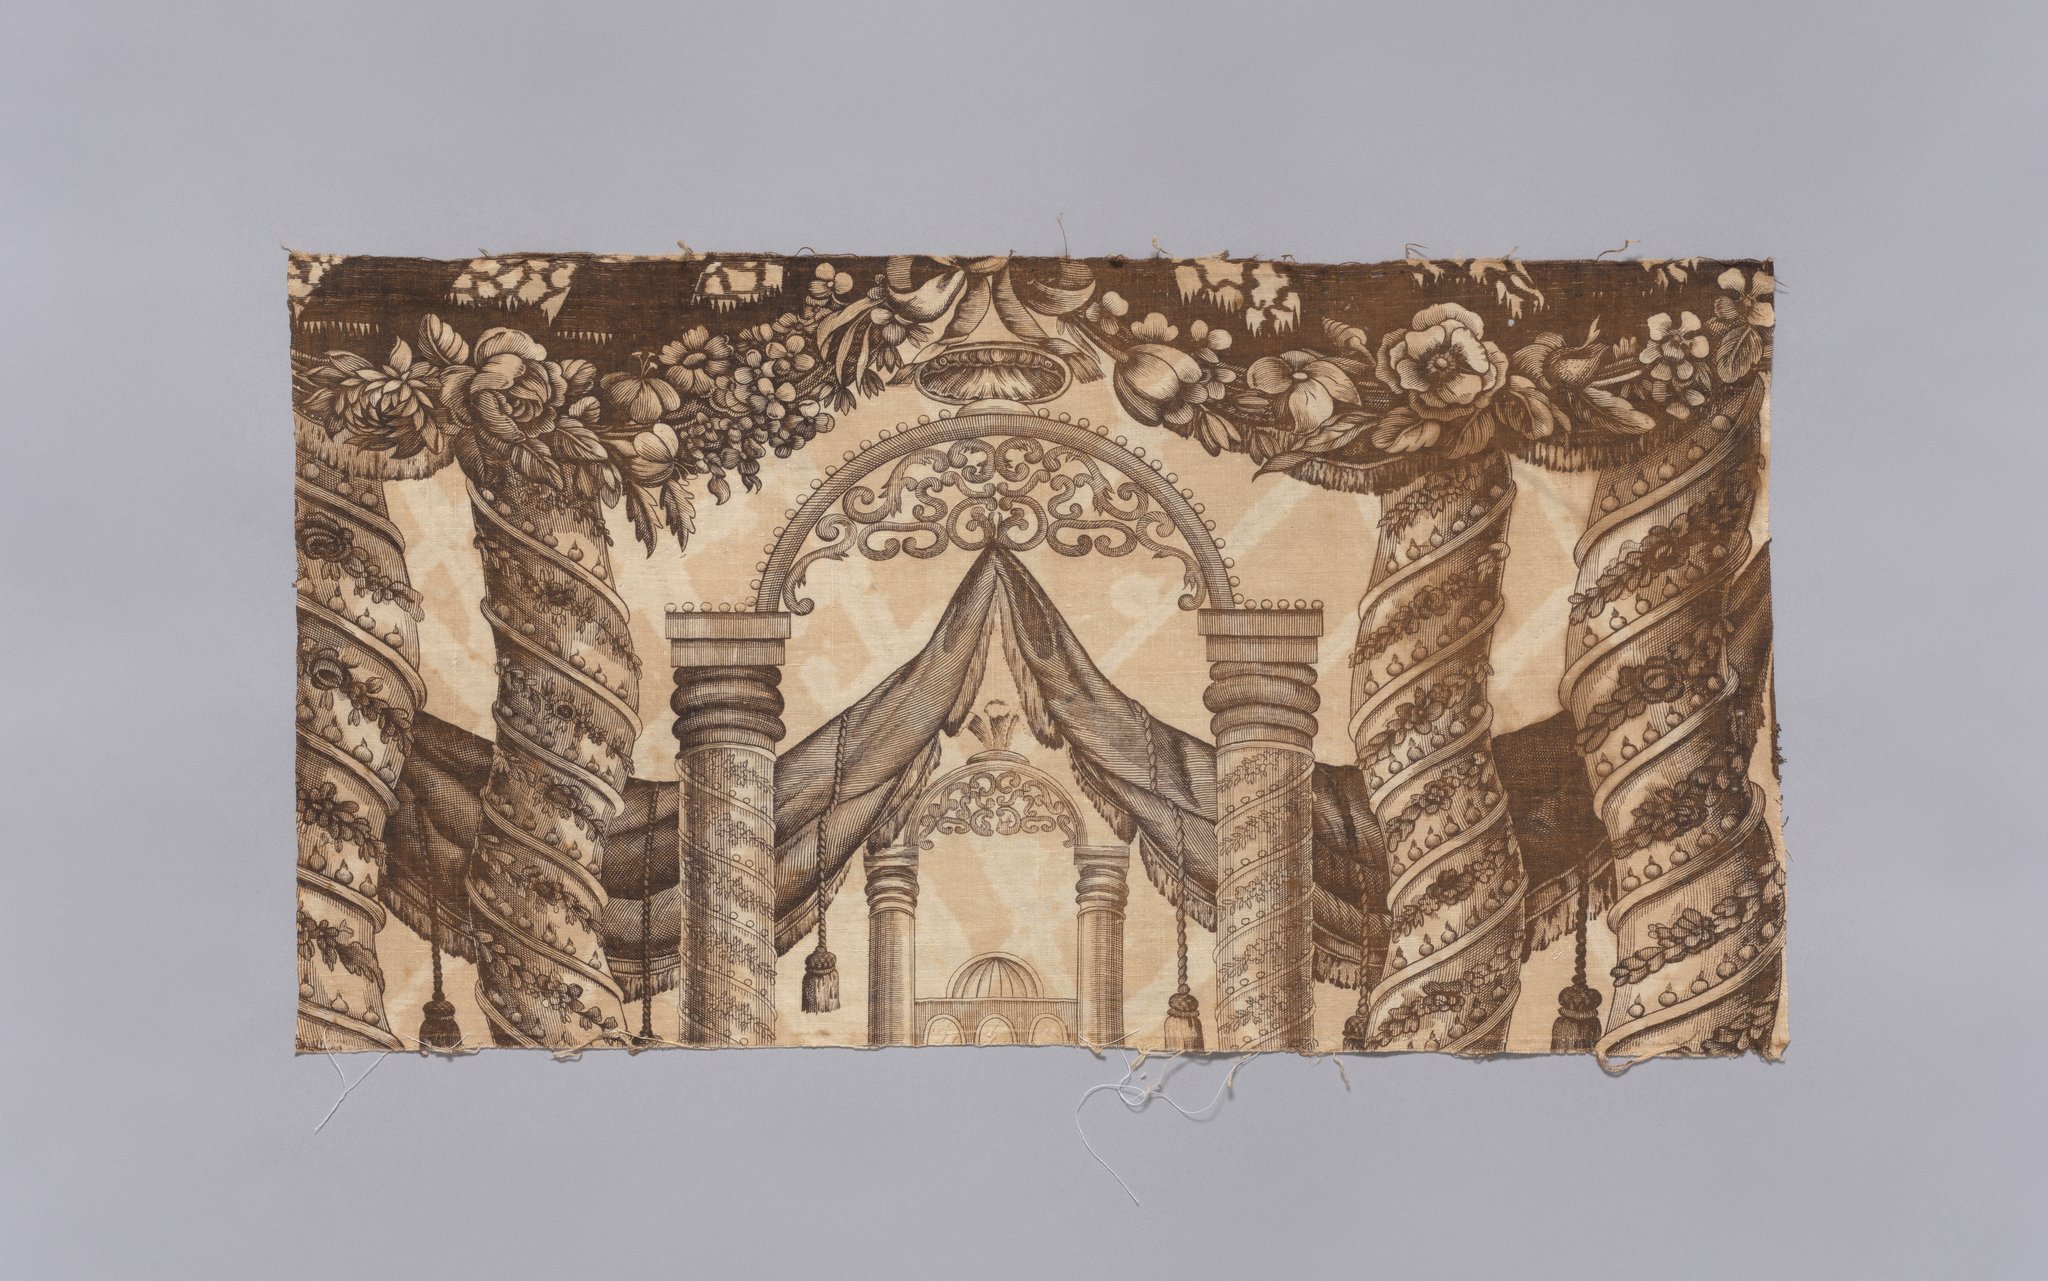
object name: fragment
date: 1801-1850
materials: cotton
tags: columns,garlands